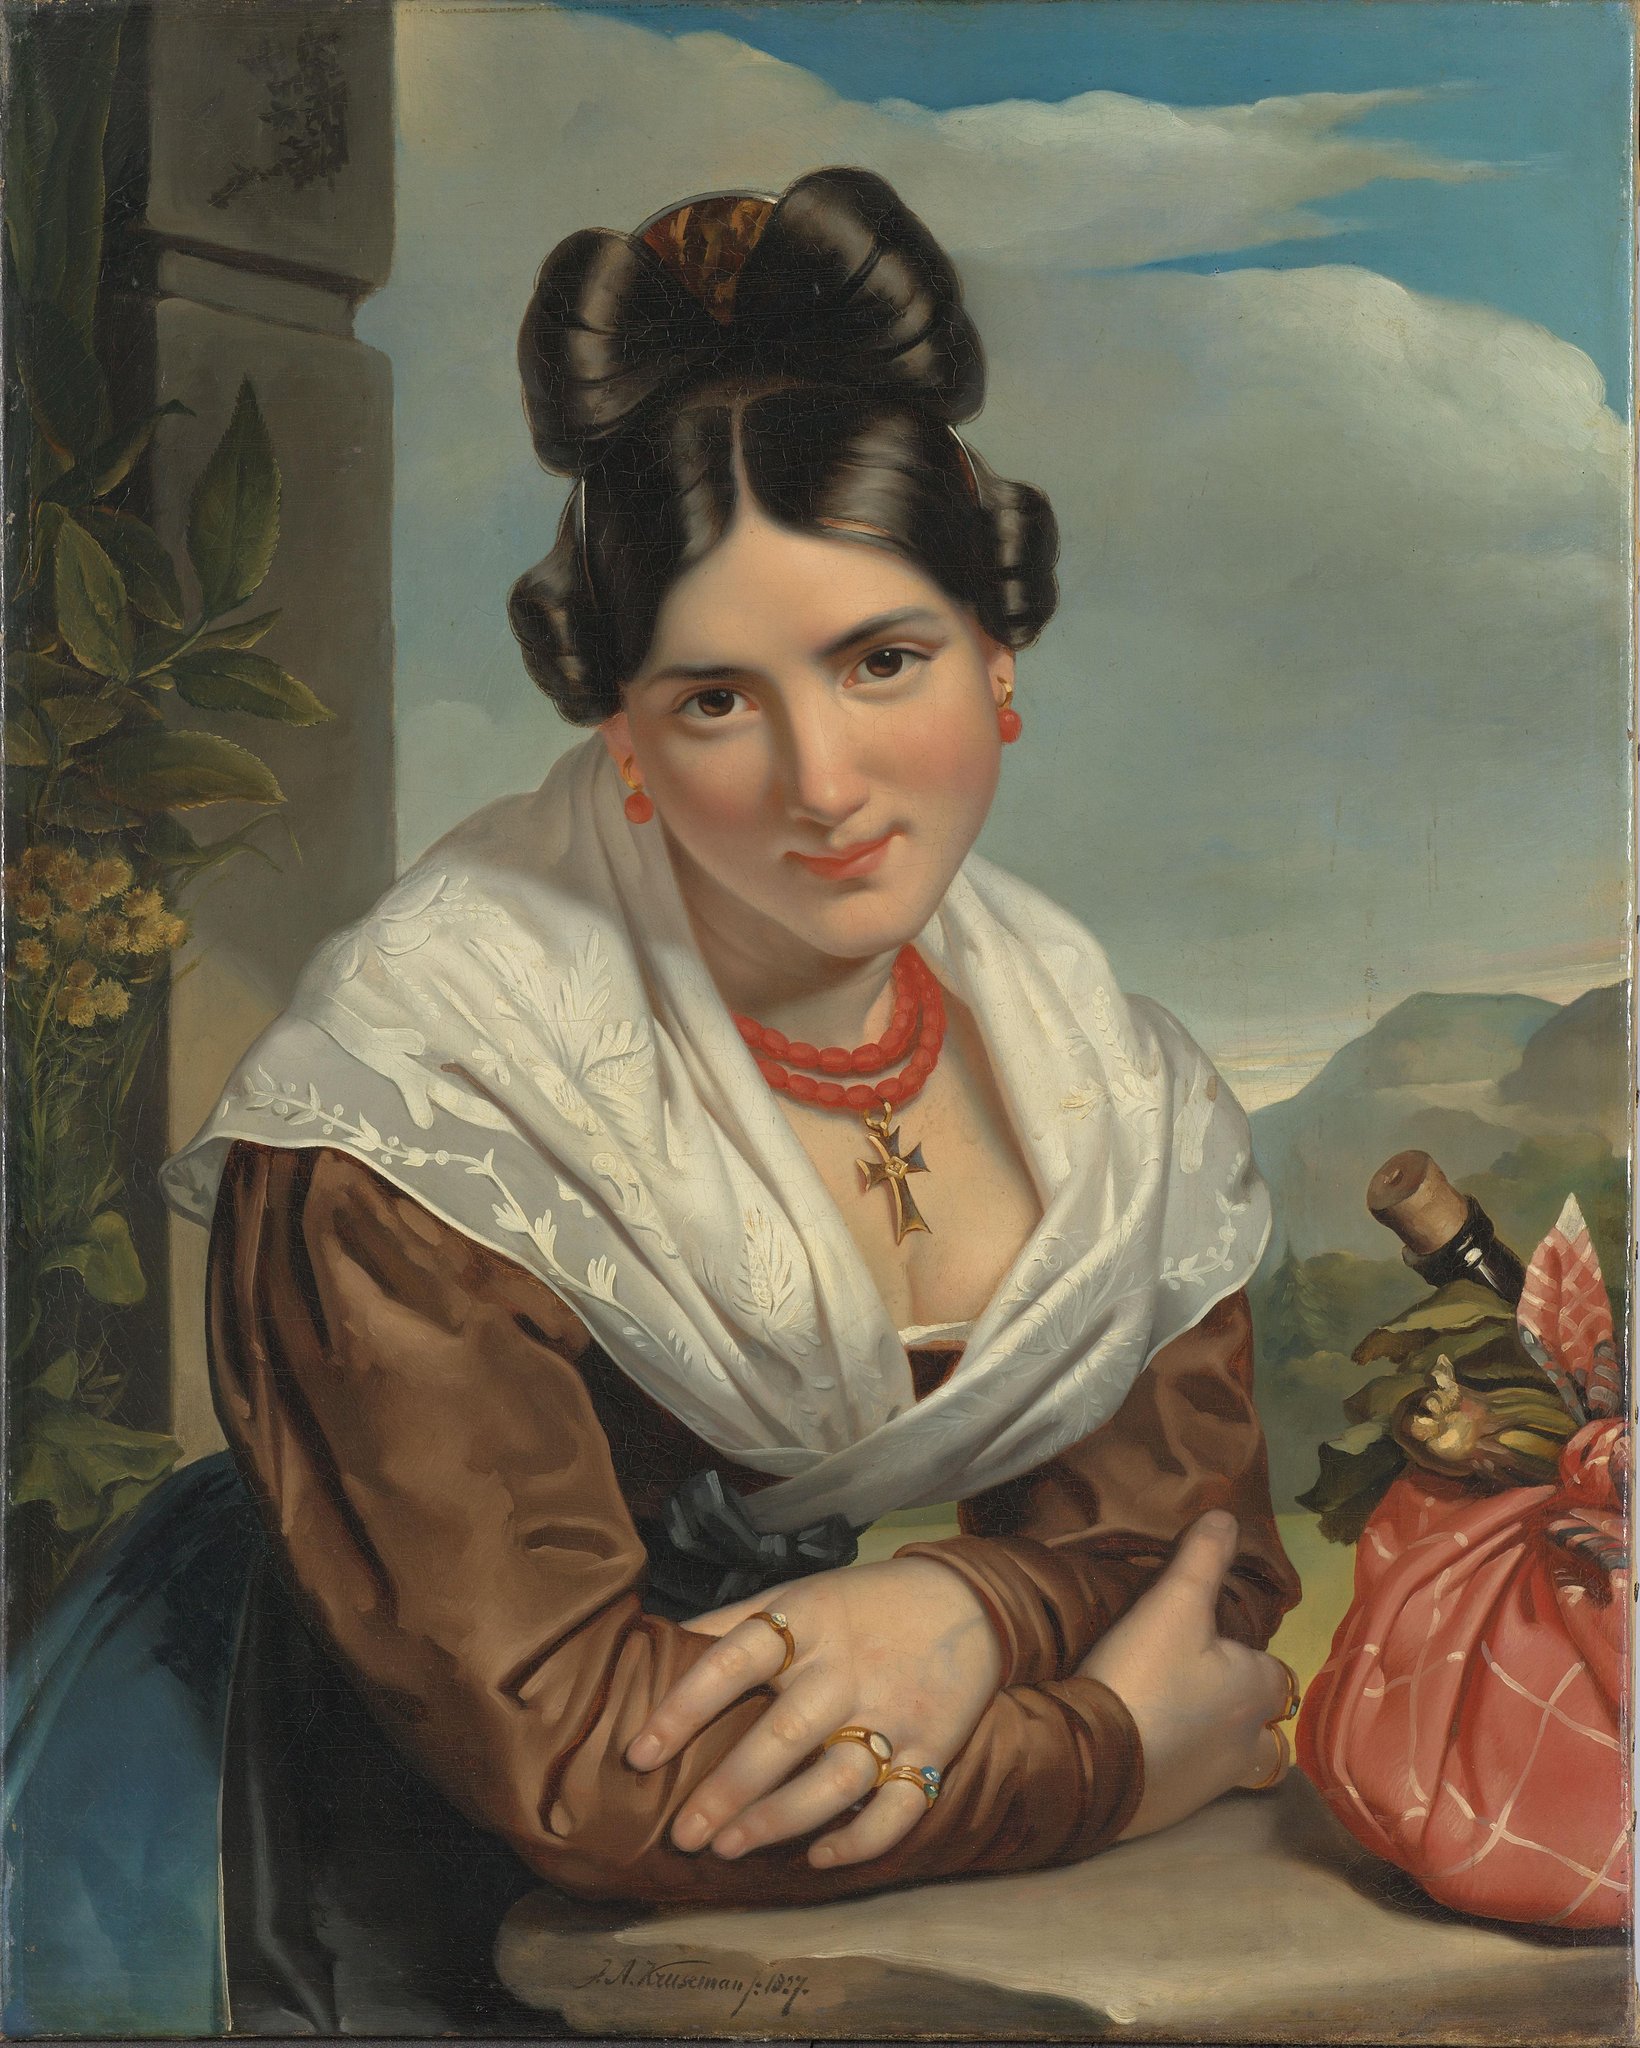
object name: painting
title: Girl Resting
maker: jan adam kruseman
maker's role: draughtsman, painter, print maker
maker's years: 1804-1862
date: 1827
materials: canvas, oil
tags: adolescent, young woman, maiden, leaning forward - aa - female human figure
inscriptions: signature and date: ‘J.A. Kruseman f: 1827’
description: Studie van jonge vrouw, glimlachend voorovergeleund met de armen op een stenen balustrade. Rechts een bundel met een fles wijn, in een doek geknoopt.